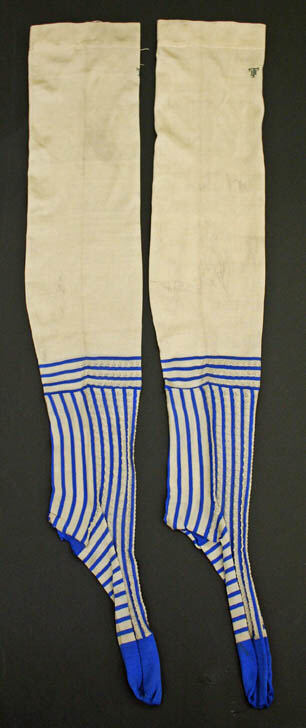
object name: stocking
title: Stockings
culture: french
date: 1801-1900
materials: silk